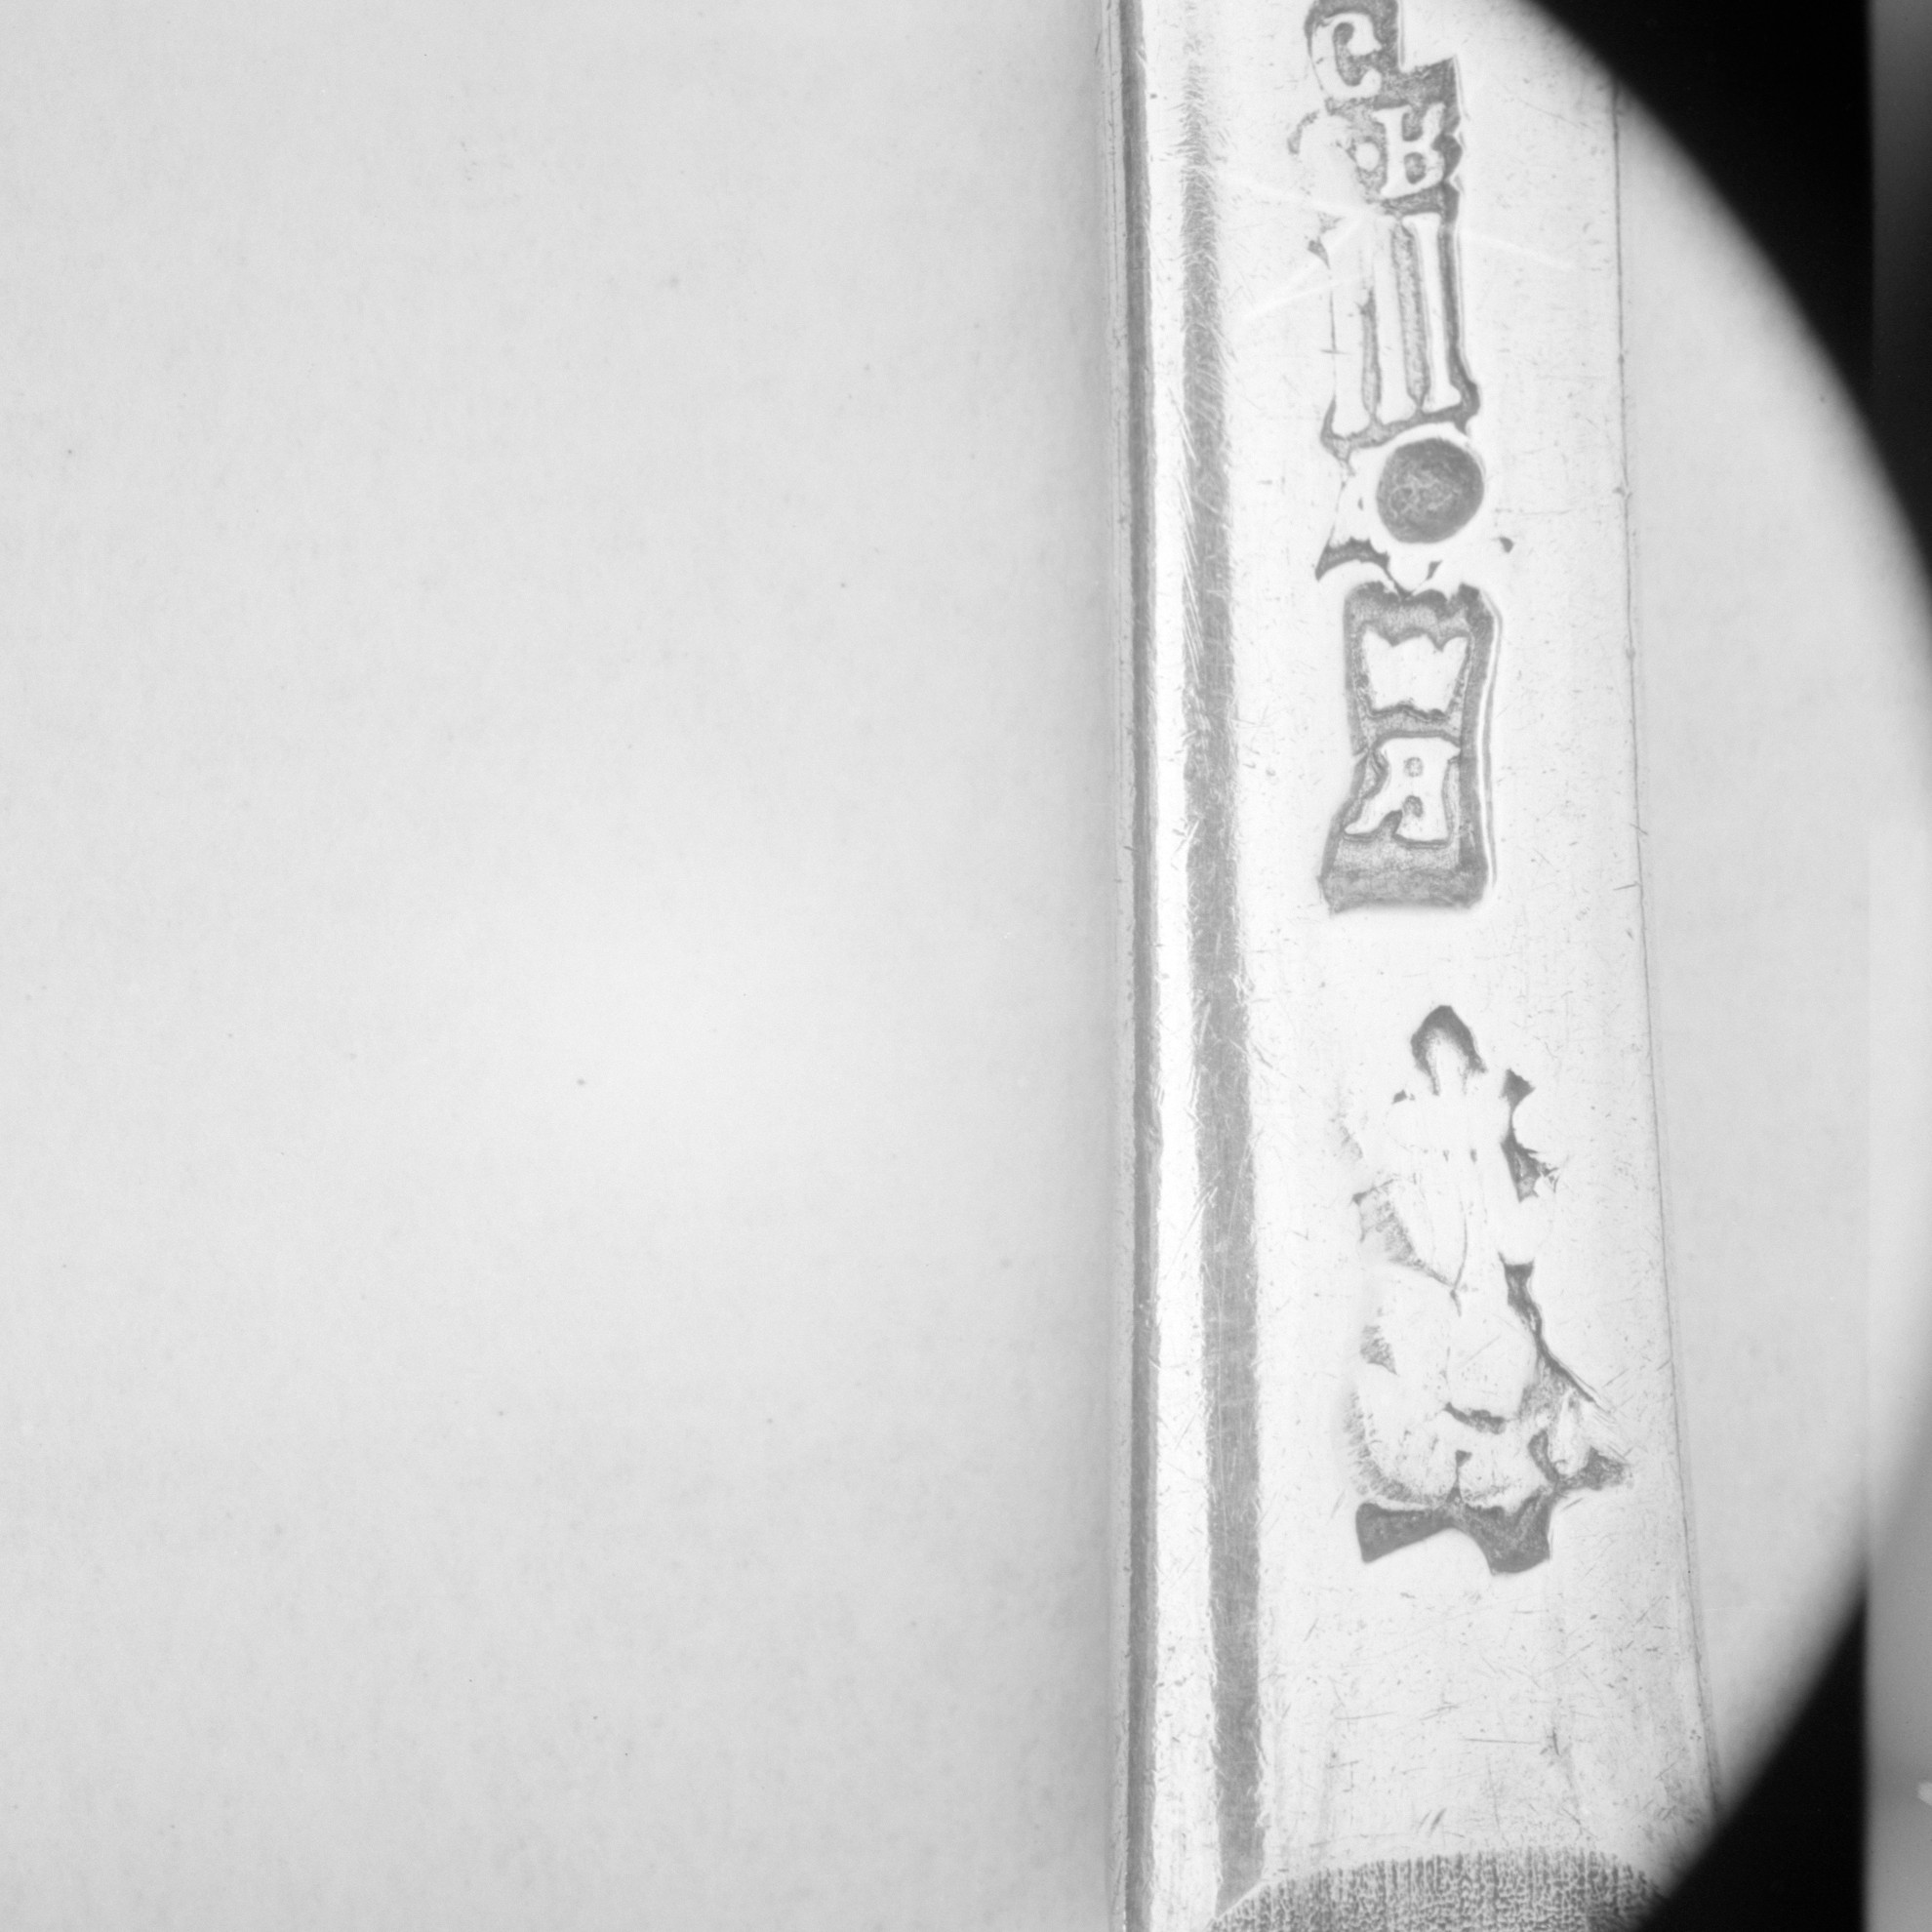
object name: spoon handle section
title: Section of a spoon handle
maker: c.r. goudelet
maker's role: maker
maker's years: 1700-1800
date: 1759-1763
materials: silver